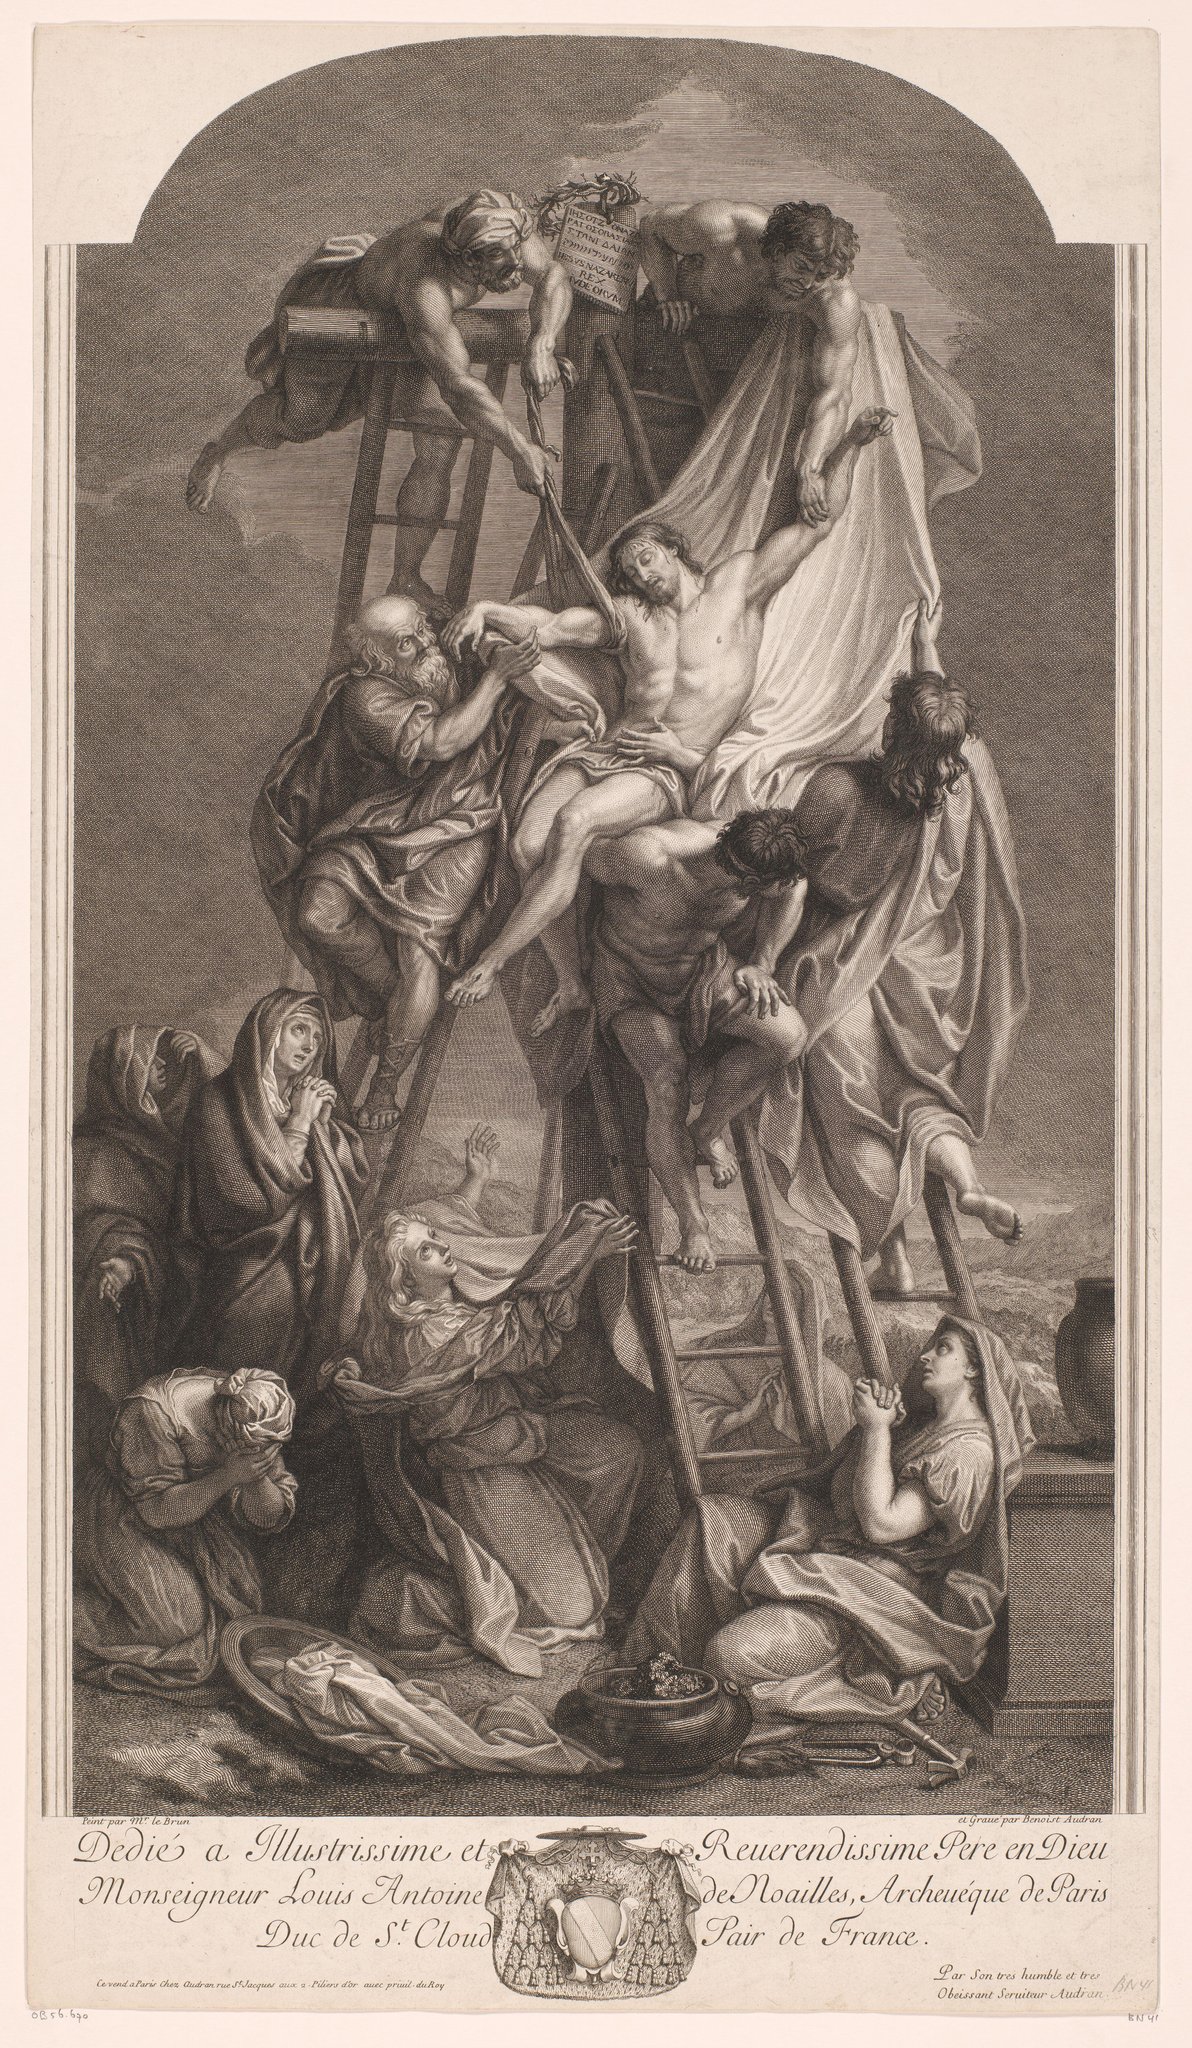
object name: print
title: Kruisafneming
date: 1671-1721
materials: paper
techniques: engraving, etching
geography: paris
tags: descent from the cross: christ is taken down from the cross, usually by nicodemus and joseph of arimathaea who are standing on the ladders (both arms of christ detached)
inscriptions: collector's mark: Lugt 240